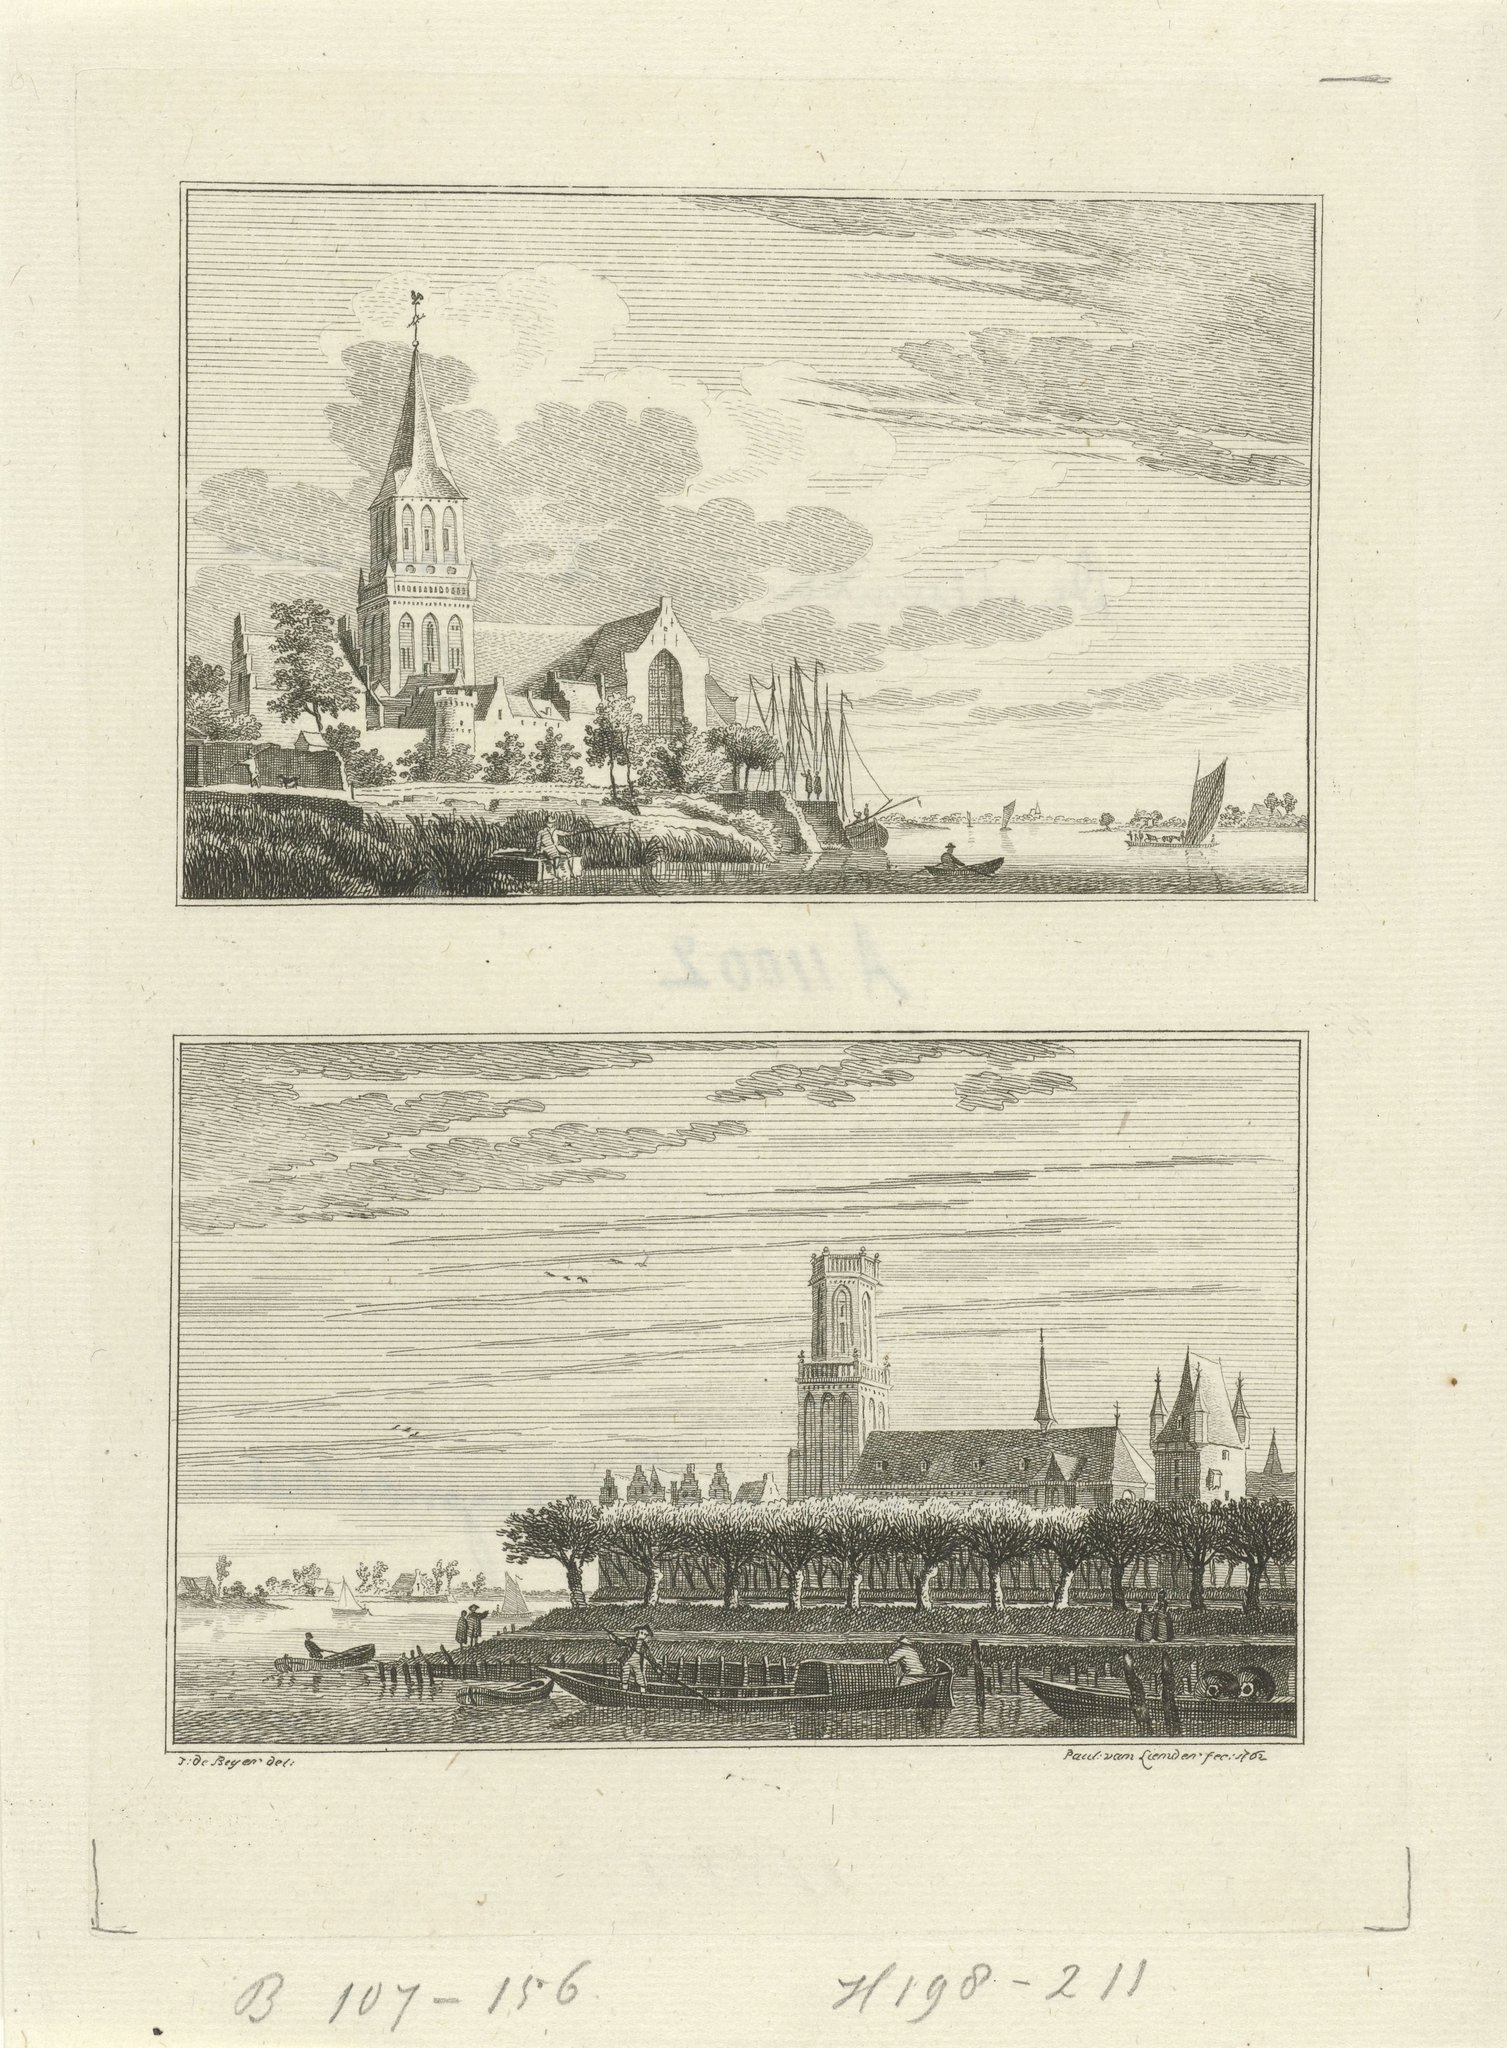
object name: print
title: Dorps- en stadsgezichten te Kleef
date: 1762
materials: paper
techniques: etching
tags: landscapes with waters, waterscapes, seascapes (in the temperate zone), church (exterior)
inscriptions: collector's mark: Lugt 2228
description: Twee voorstellingen van één plaat. Gezichten op de Munsterkerk (boven) en de Sint-Aldegondekerk (onder) aan de Rijn te Emmerik, Duitsland. De prent maakt deel uit van een 100-delige serie met gezichten op dorpen en steden te Kleef.